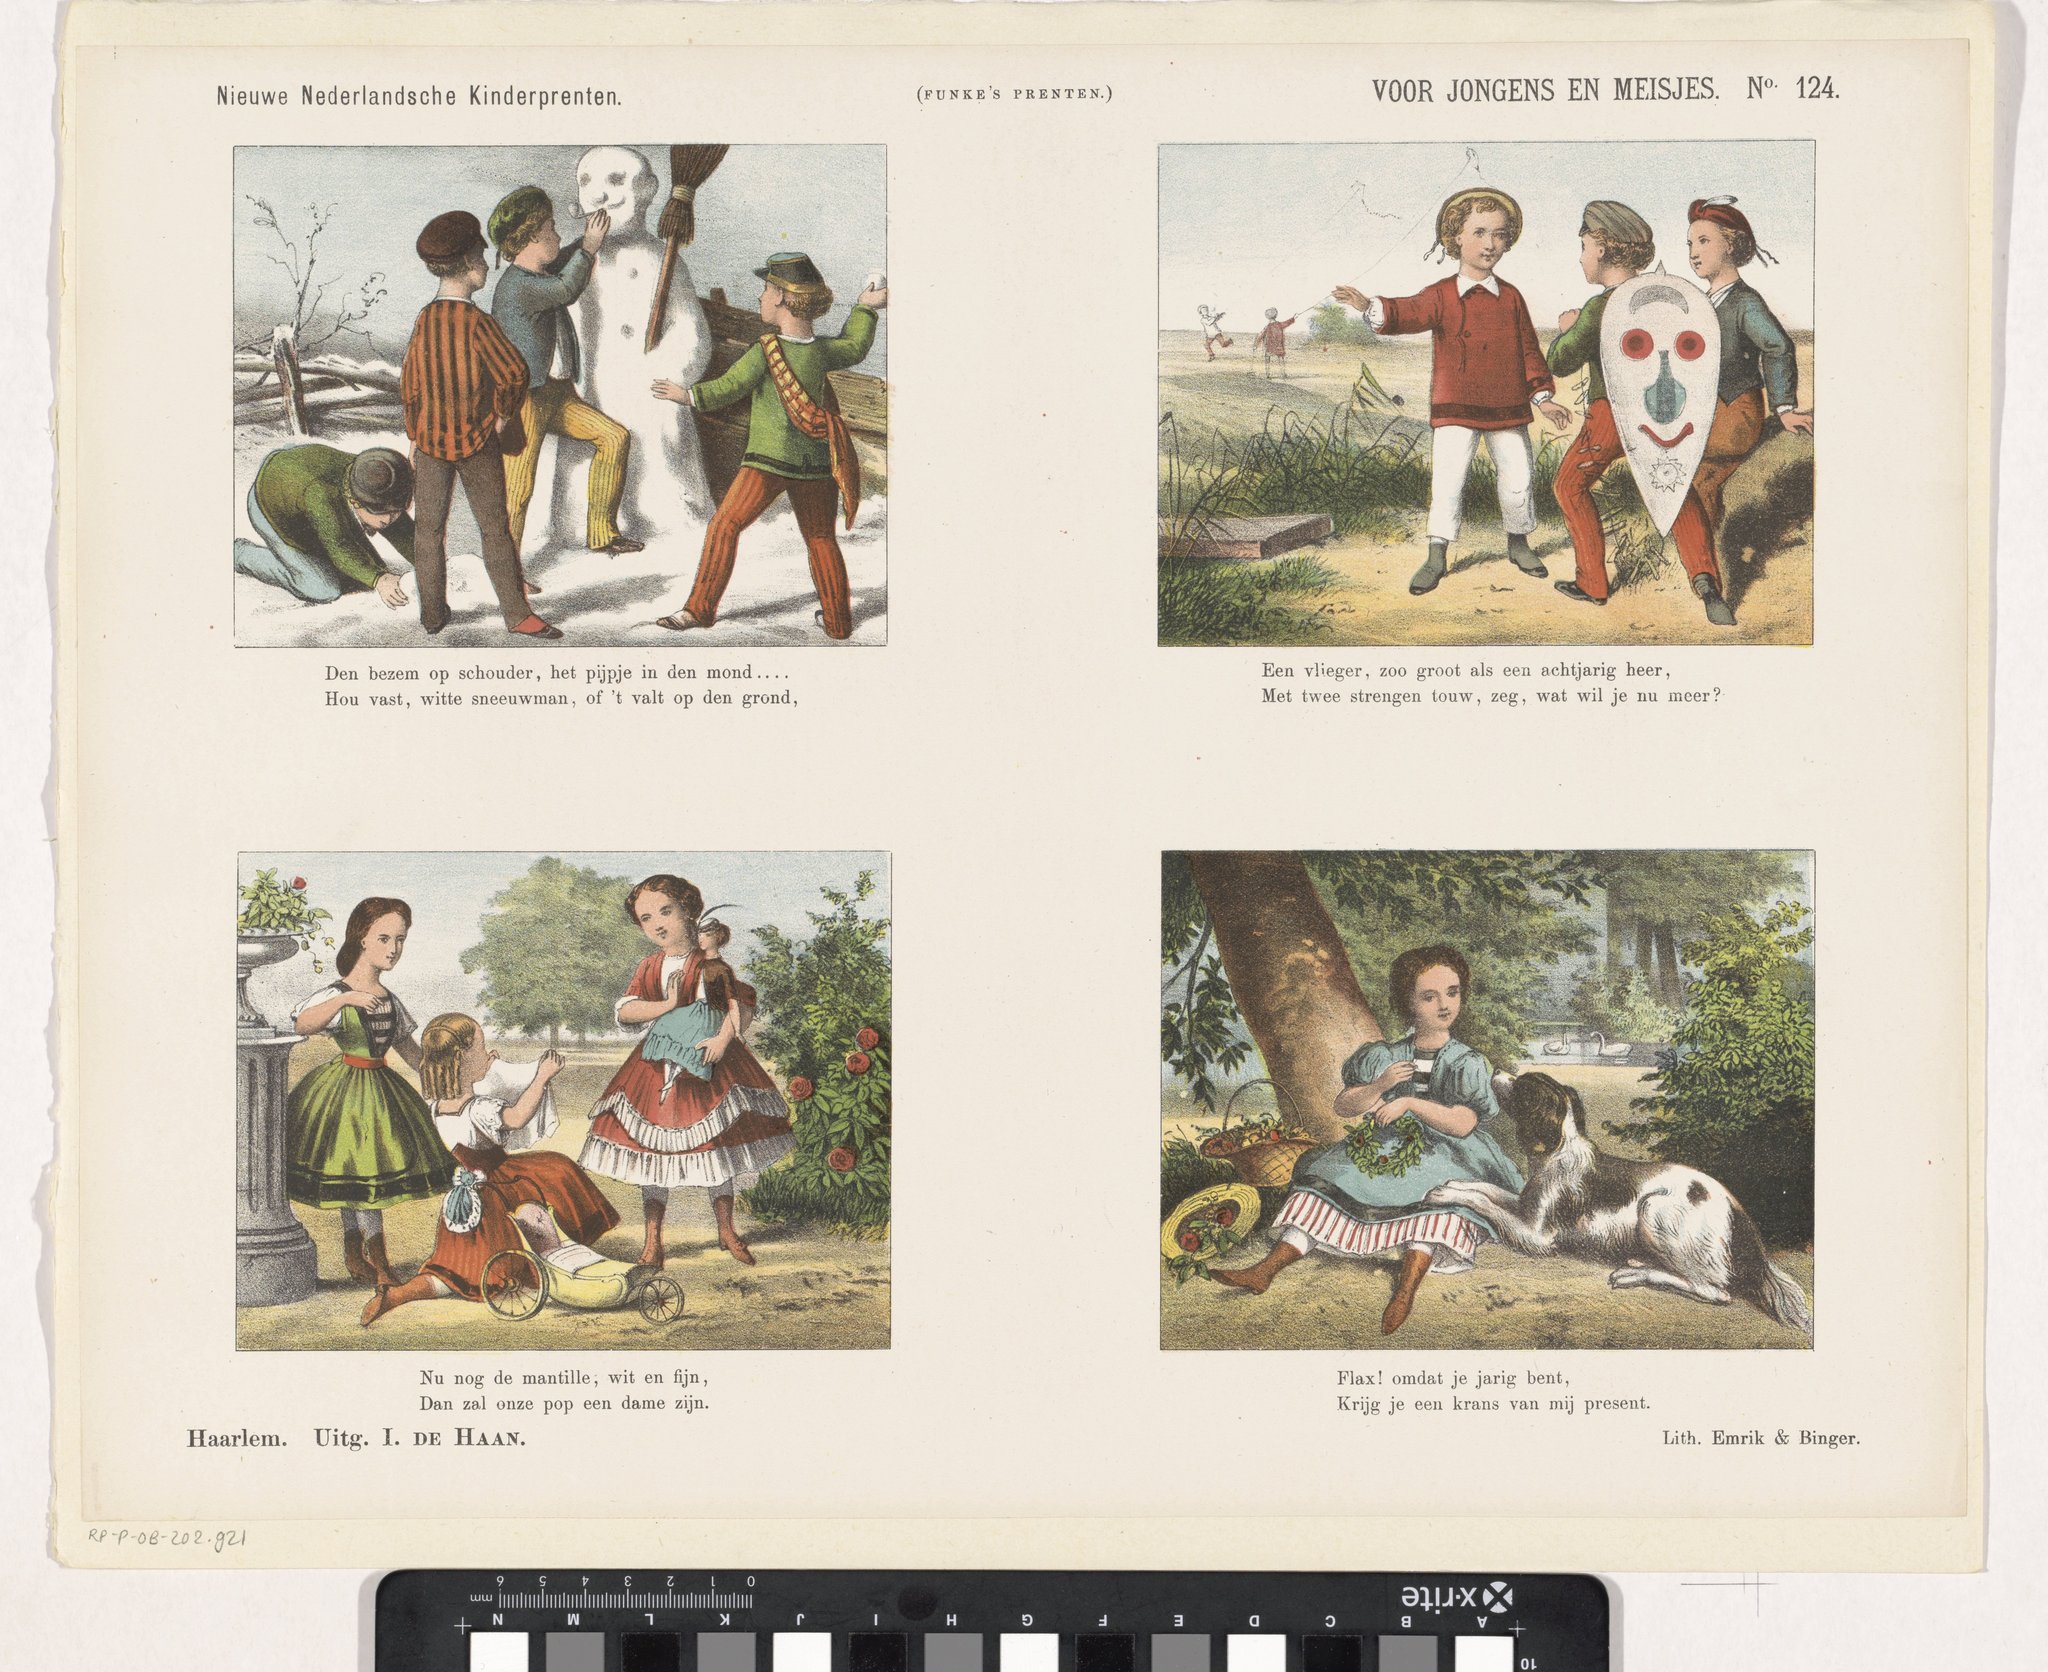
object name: print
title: Voor jongens en meisjes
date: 1875-1903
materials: paper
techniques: lithograph, letterpress printing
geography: haarlem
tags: children's games and plays, (making a) snowman, (playing with) dolls, child playing with animals, (flying a) kite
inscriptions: collector's mark: Lugt 2760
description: Blad met 4 voorstellingen van kinderspelen, zoals een sneeuwpop maken, vliegeren en met de pop spelen. Onder elke voorstelling een tweeregelig vers. Genummerd rechtsboven: No. 124.